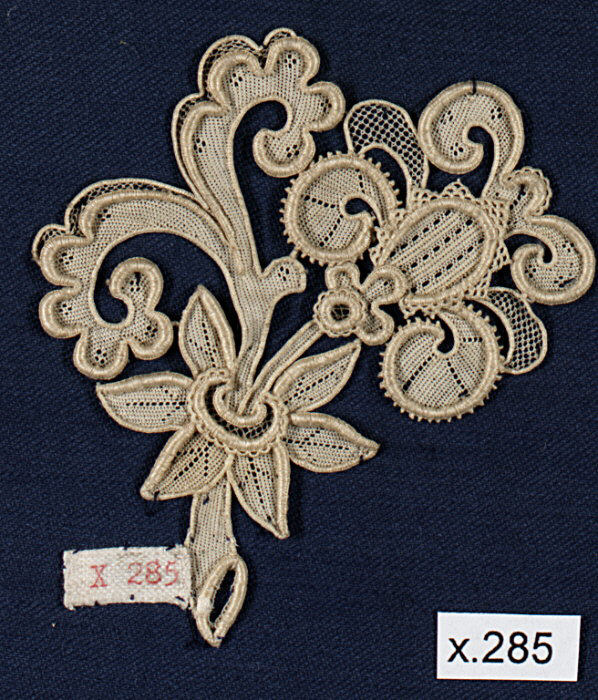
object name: ornament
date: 1801-1900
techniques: lace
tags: flowers